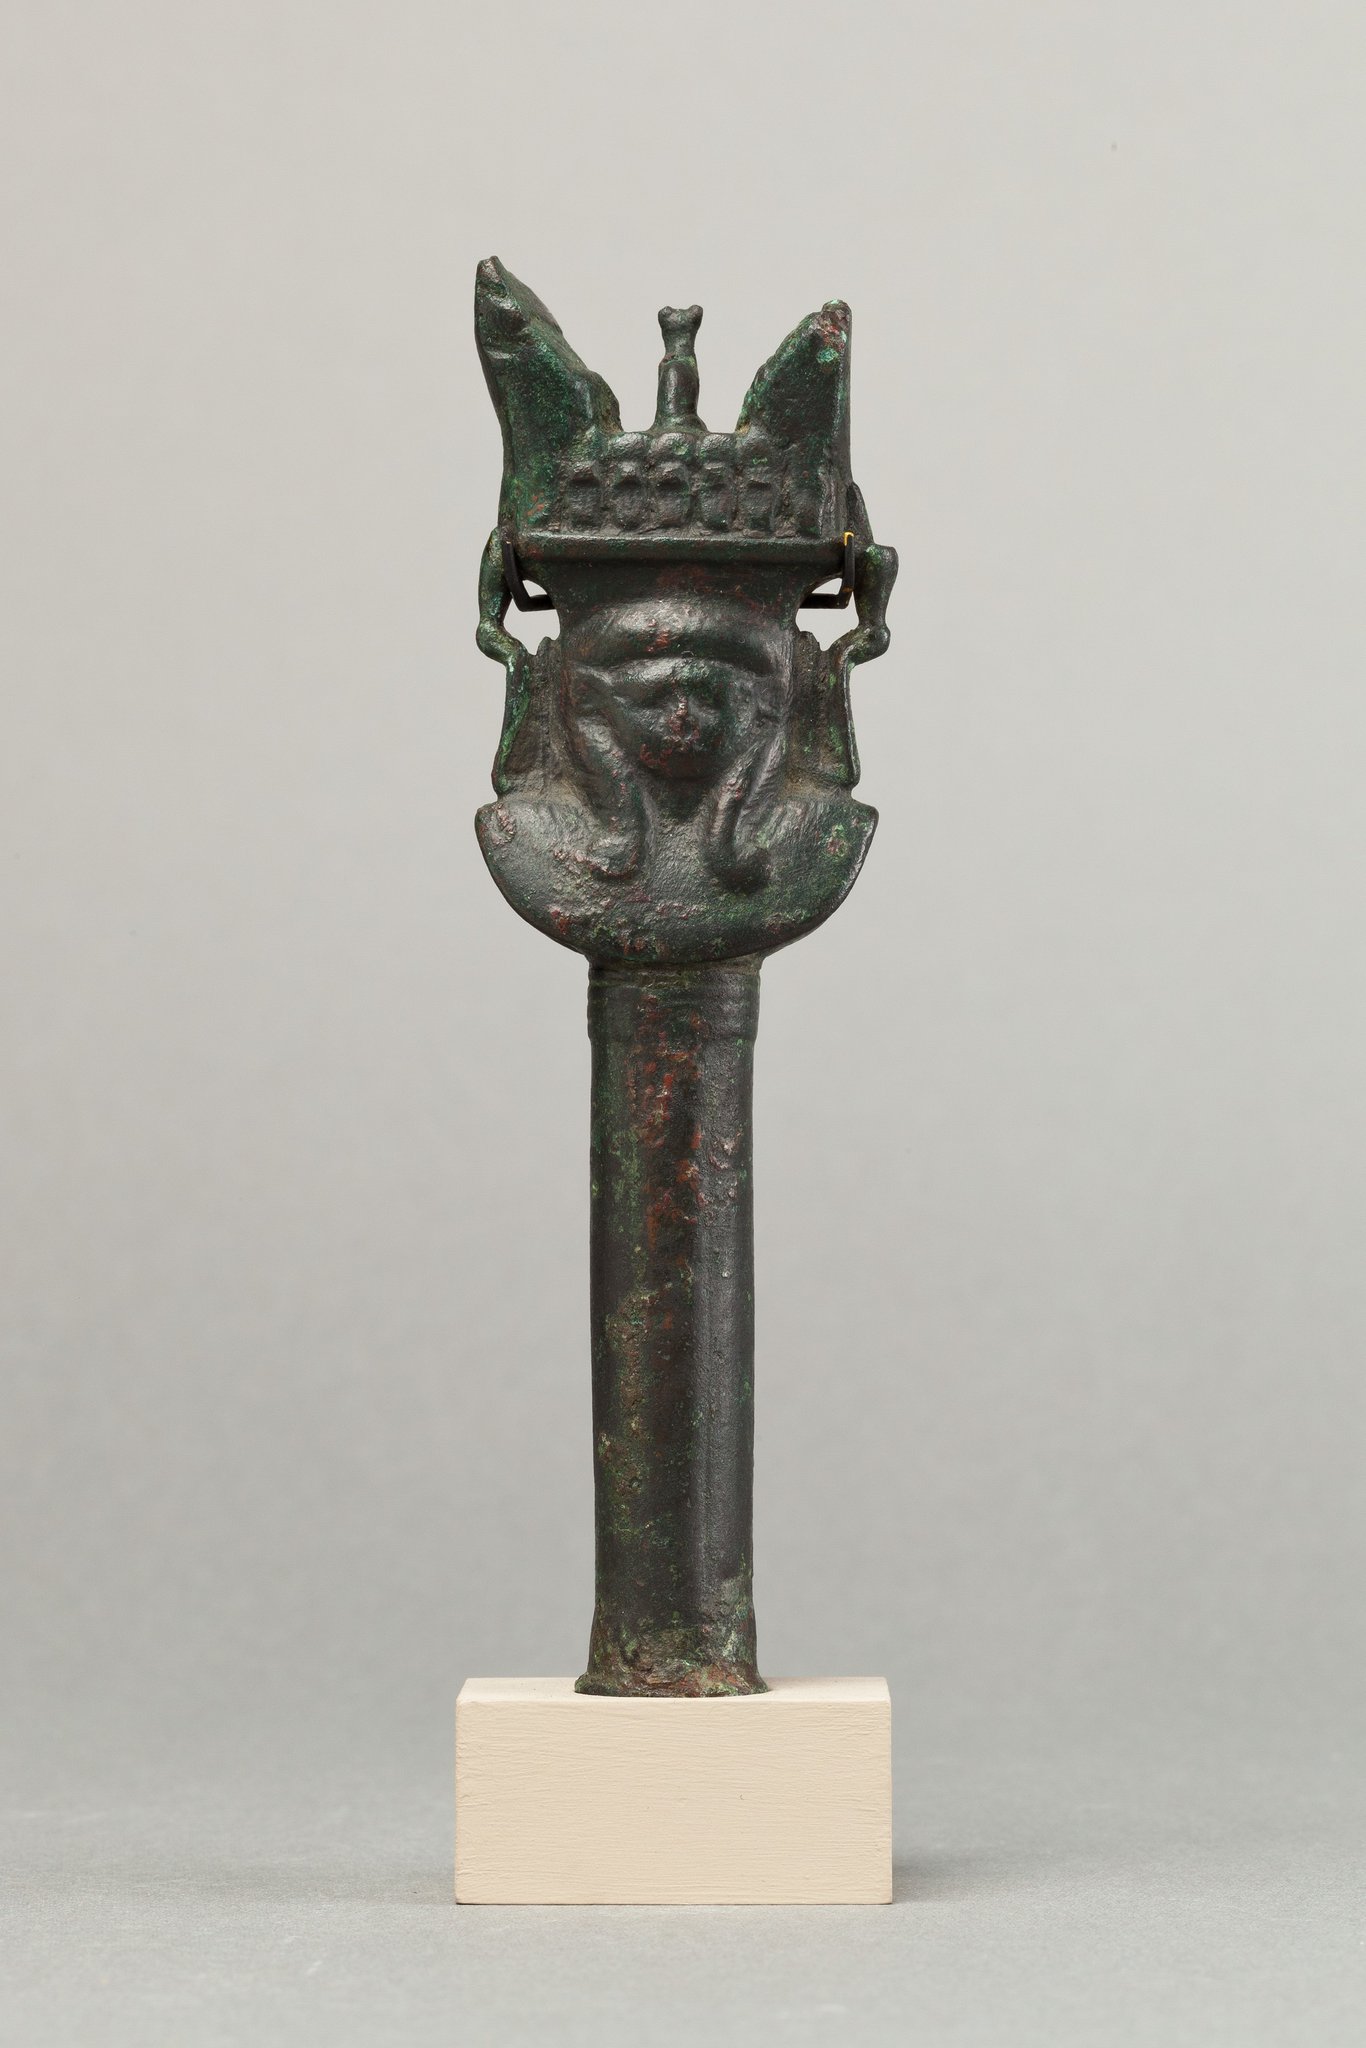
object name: music, sistrum, hathor emblem, bat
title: Handle of sistrum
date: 664-630 BCE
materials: metal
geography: egypt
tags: musical instruments,heads